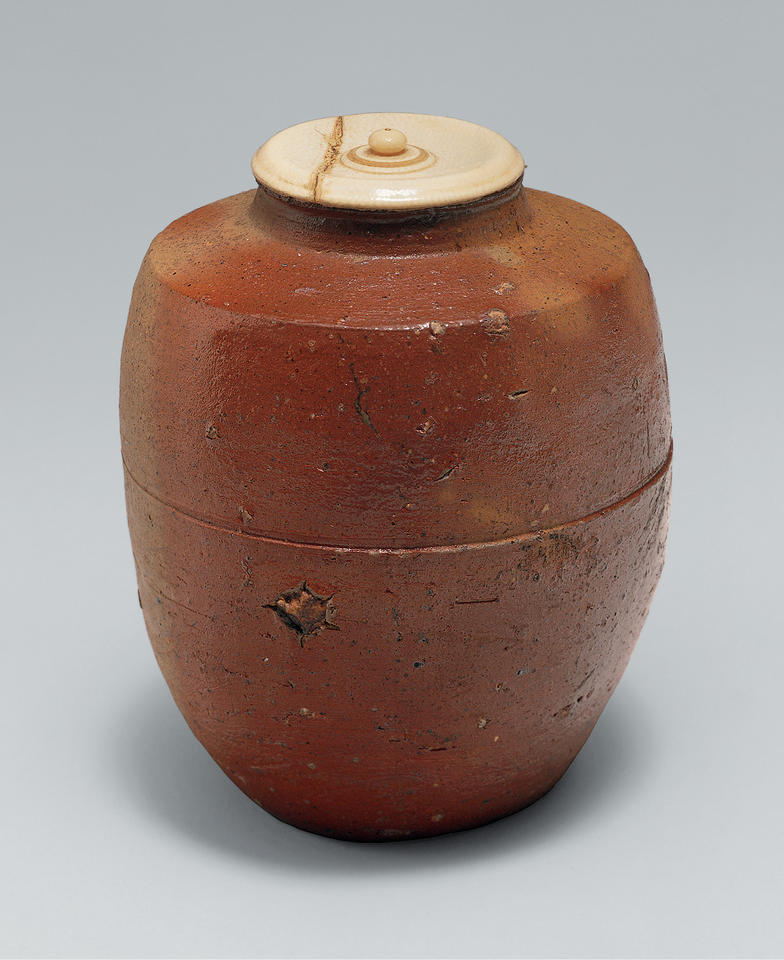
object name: tea caddy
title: Tea Caddy (Chaire)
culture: japanese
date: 1567-1600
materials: wood, glaze, stoneware